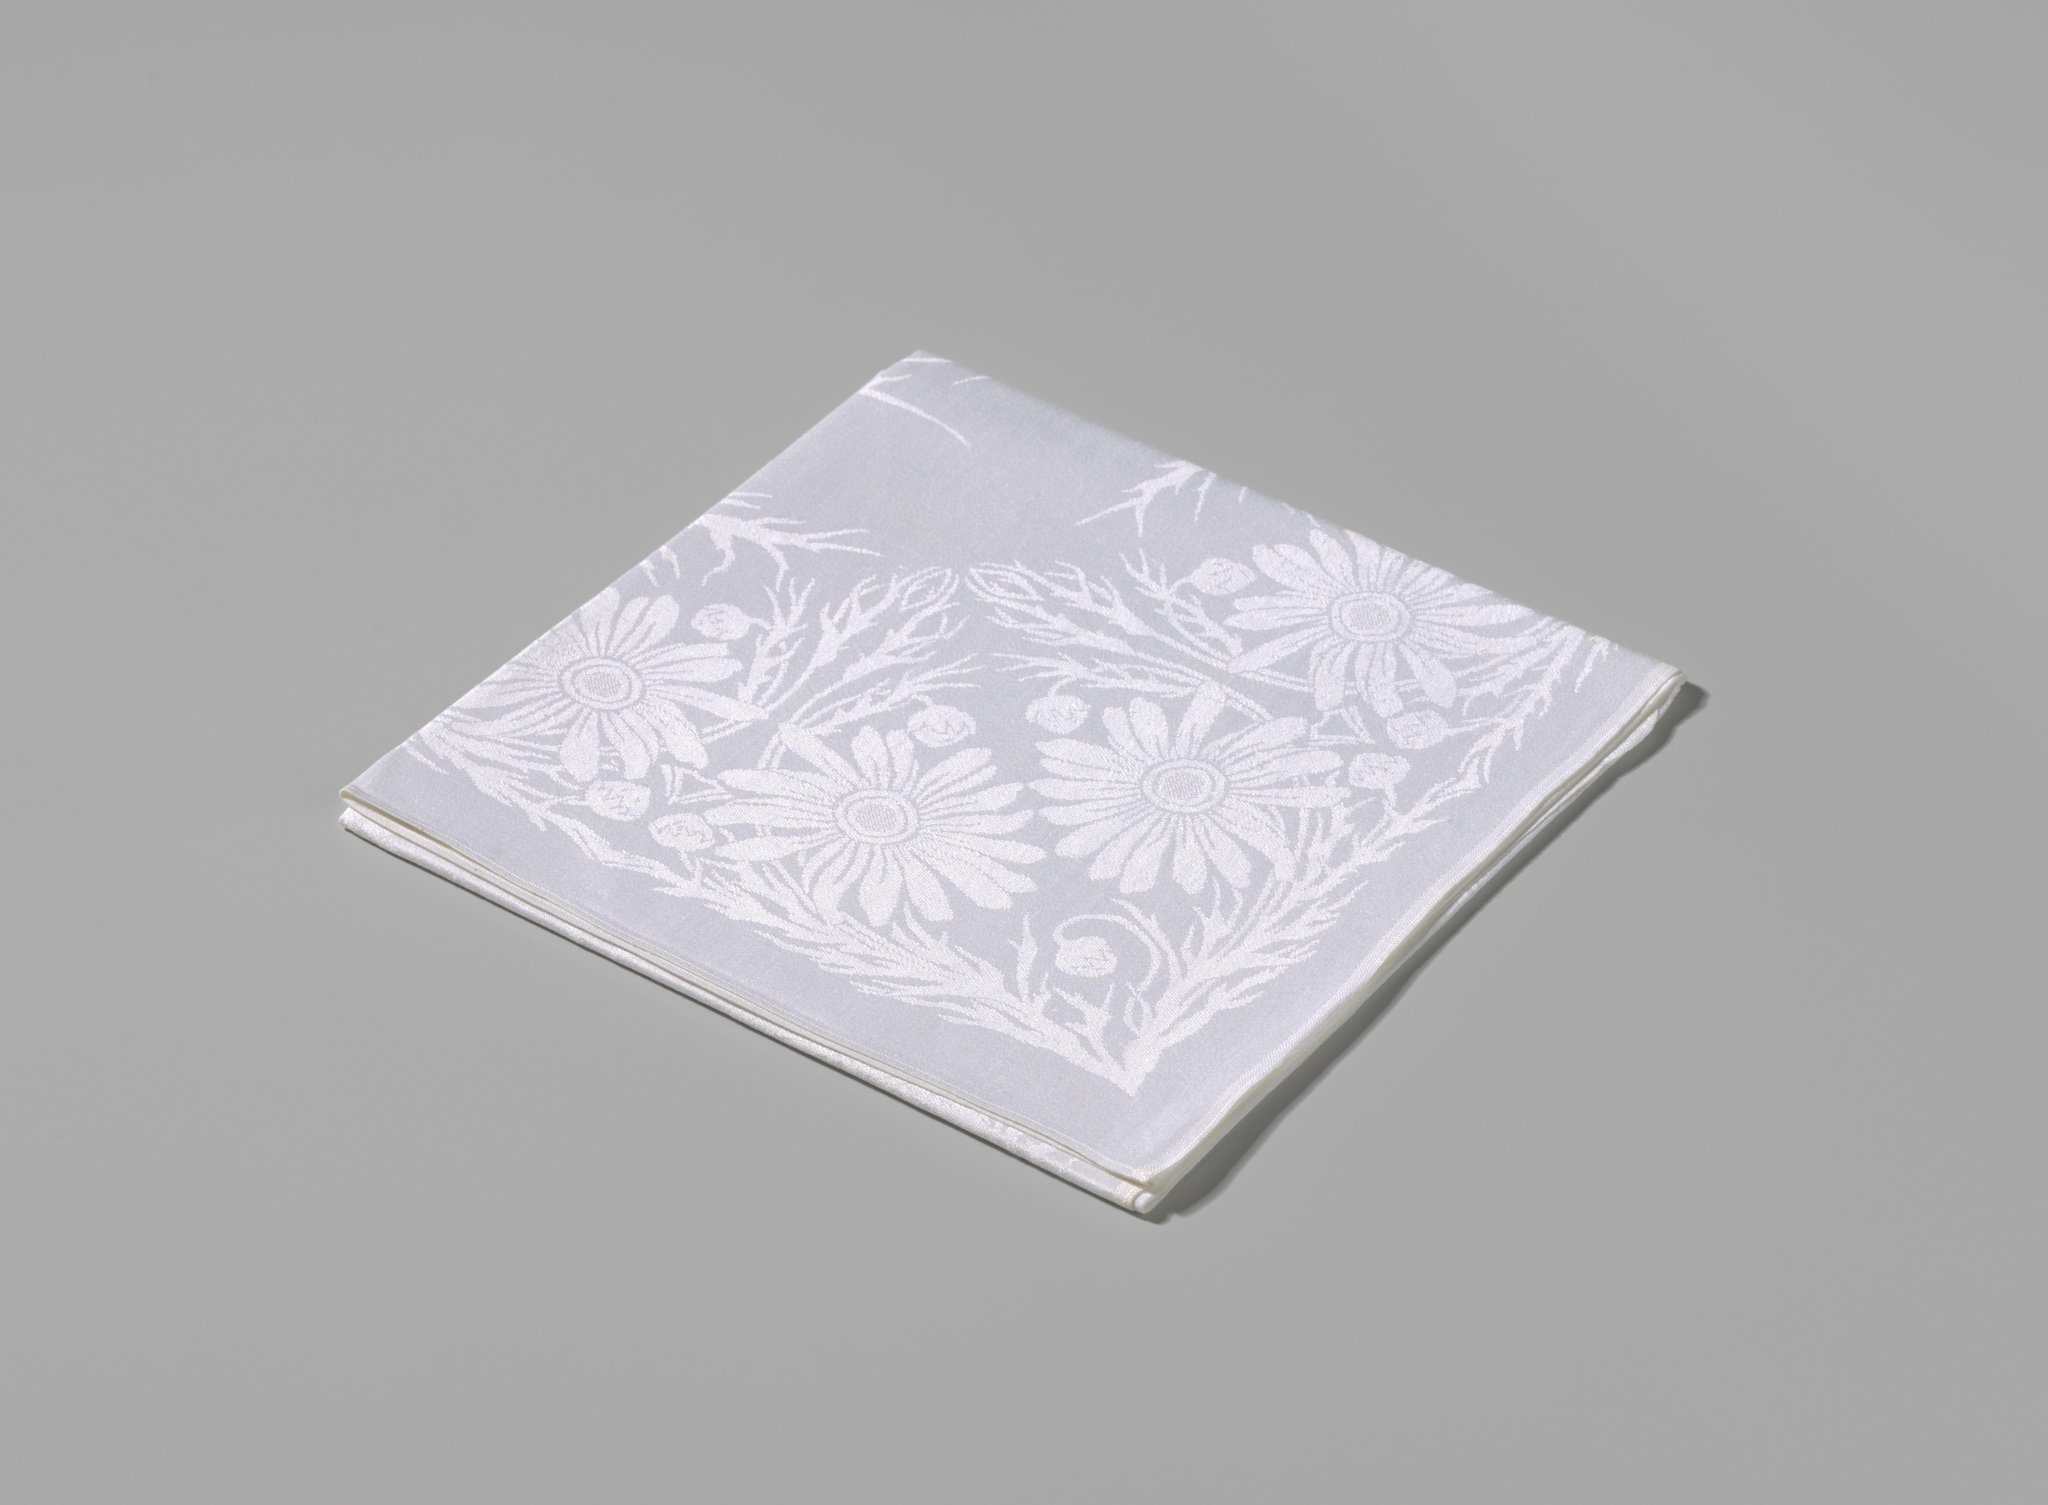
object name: napkin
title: Servet van linnendamast met dessin Marguerite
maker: cornelis van der sluys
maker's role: print maker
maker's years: 1881-1944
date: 1904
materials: linen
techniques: damask, weave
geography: eindhoven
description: Servet van linnendamast met een bloempatroon: motief Marguerite, dessin nr. 500. Het servet hoort bij twaalf servetten, twaalf vingerdoeken en een tafellaken.